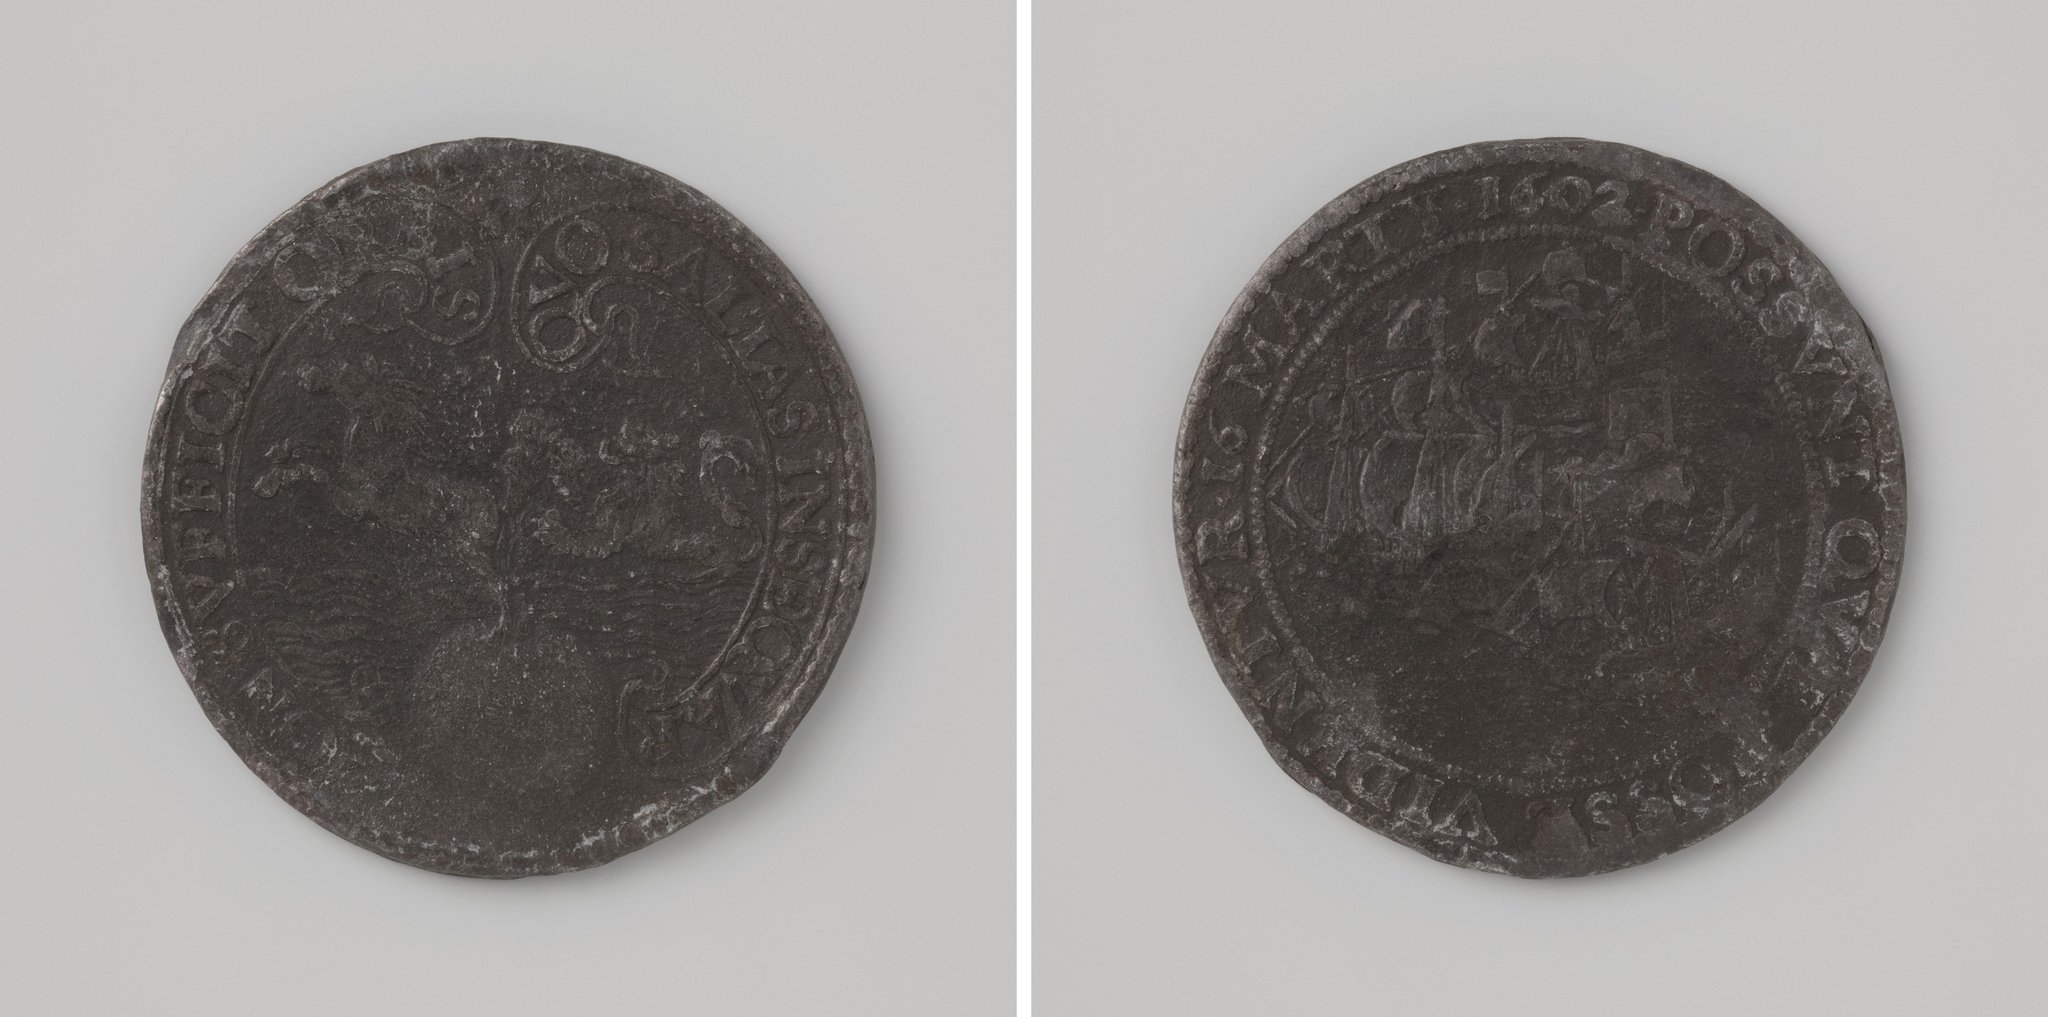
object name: history medal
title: De verovering van het Spaanse galjoen St. Jacob door de Zeeuwse schepen van De Roy en Bikker 1601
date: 1602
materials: tin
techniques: casting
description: Tinnen penning, op de voorzijde een paard dat naar de andere zijde van de wereld springt, gevolgd door de Zeeuwse leeuw, met een omschrift op twee linten waartussen een burchtje, op de keerzijde drie schepen op volle zee, met omschrift.